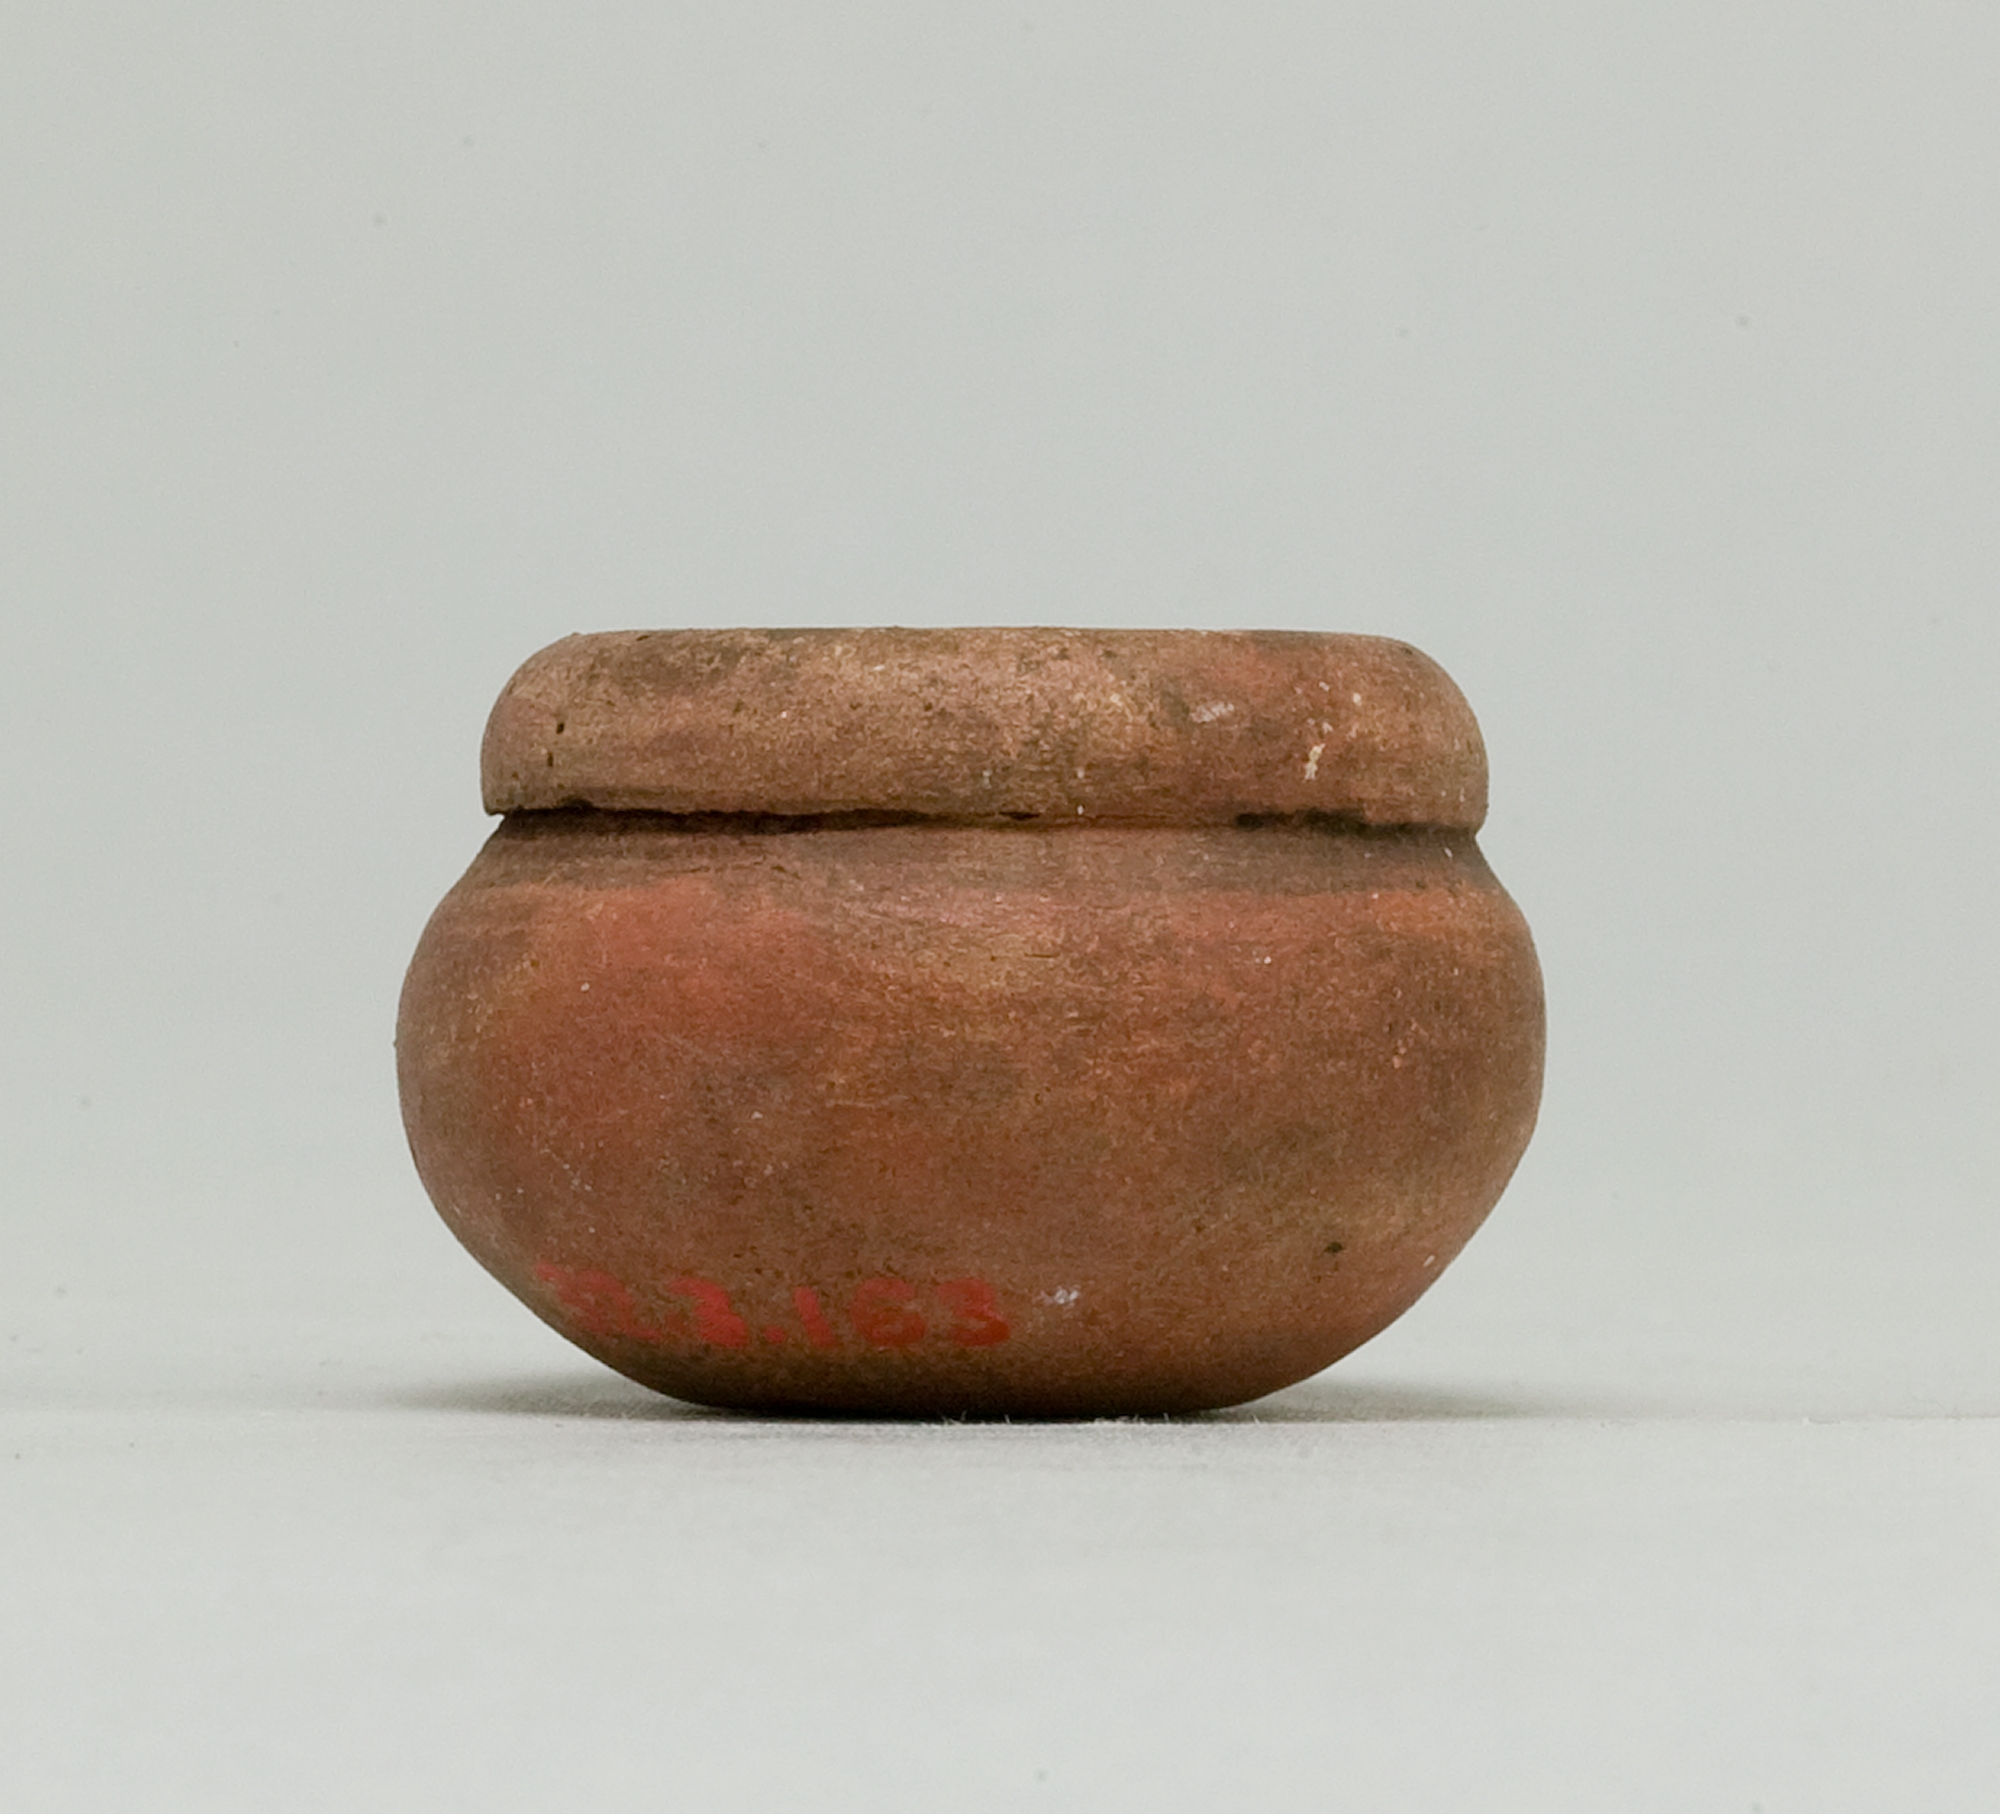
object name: kohl jar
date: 2030-1640 BCE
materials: pottery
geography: egypt